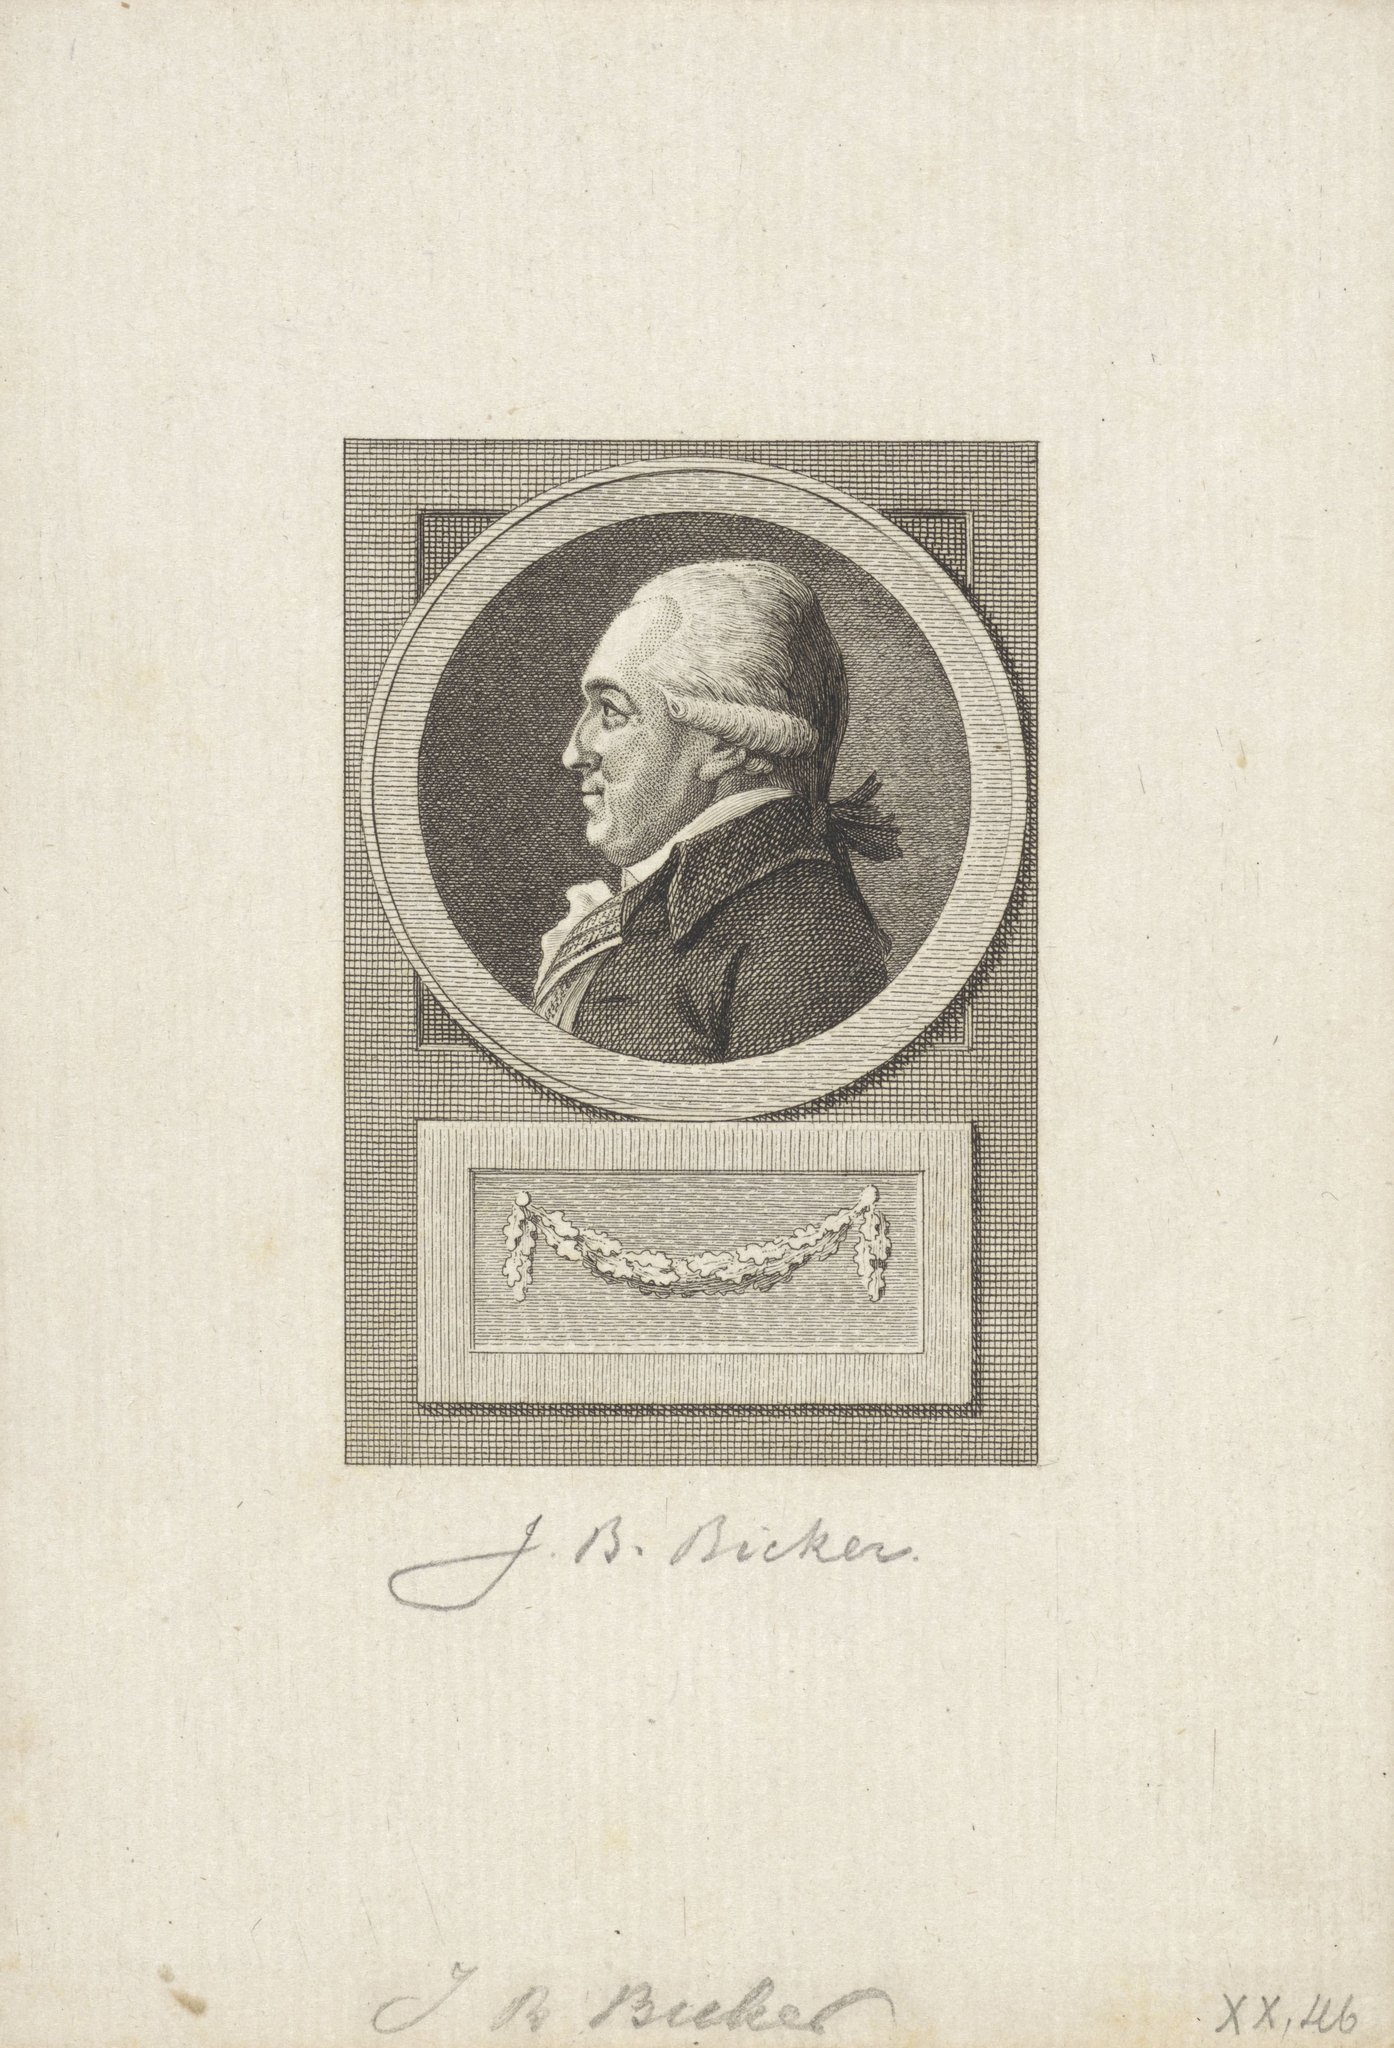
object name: print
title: Portret van Jan Bernd Bicker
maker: reinier vinkeles (i)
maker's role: draughtsman, print maker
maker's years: 1741-1816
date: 1783-1795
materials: paper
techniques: engraving, etching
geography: amsterdam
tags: amsterdam, the hague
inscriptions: collector's mark: Lugt 2228, inscription: ‘J.B. Bicker XX, 46’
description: Latere staat prent gebruikt in: Fokke, Jan. Geschiedenissen der Vereenigde Nederlanden voor de vaderlandsche jeugd Ie-XXVste deel. Amsterdam: Johannes Allart, 1783-1795. Deel XX.